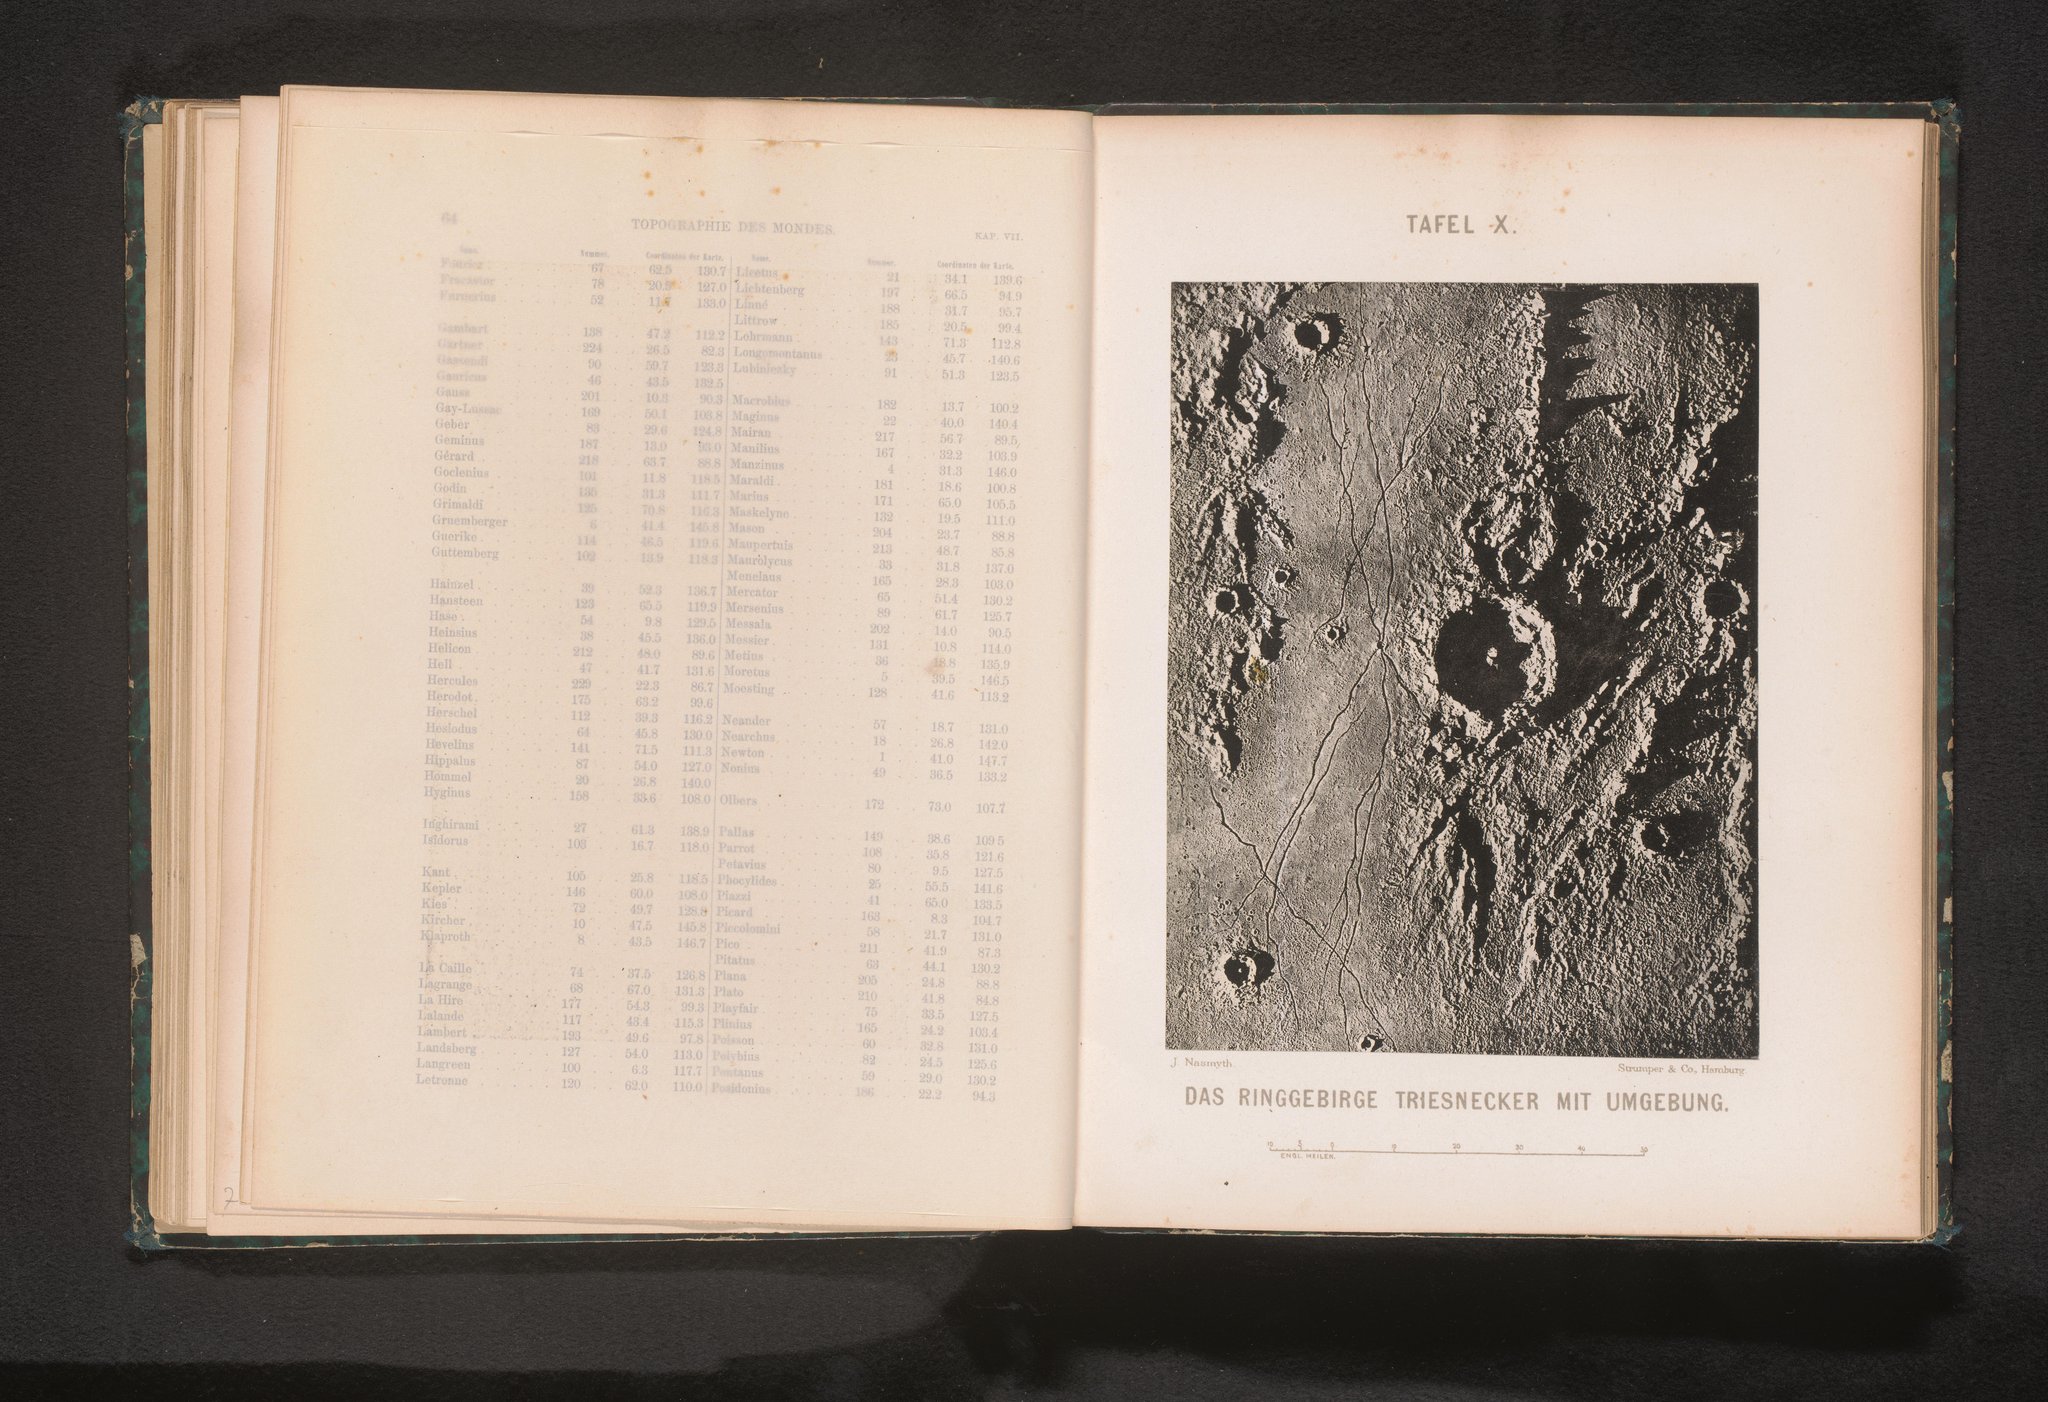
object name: photomechanical print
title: Gipsmodel van de maankrater Triesnecker, van bovenaf gezien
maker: james nasmyth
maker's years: 1808-1890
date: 1863-1873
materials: paper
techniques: photograph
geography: hamburg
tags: surface of the moon, moon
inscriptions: number: ‘Tafel X.’